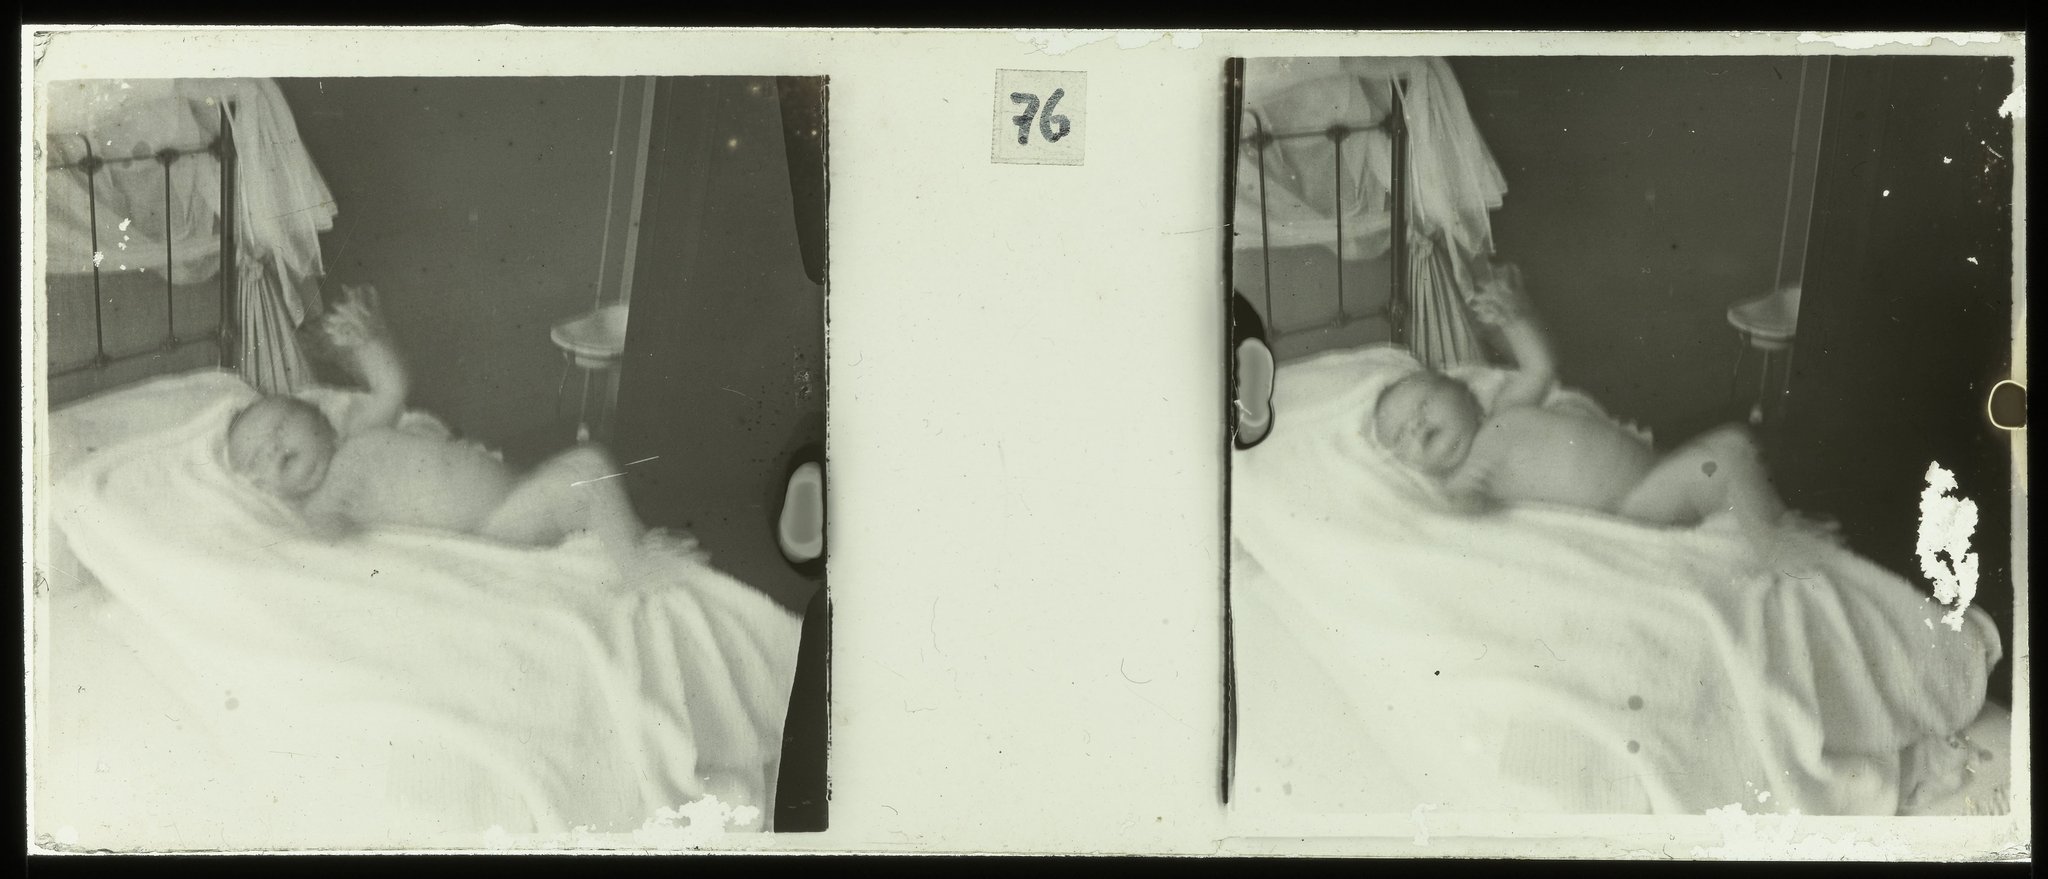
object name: stereograph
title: Gerard Brouwers, de pasgeboren zoon van planter Theodoor Brouwers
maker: theodoor brouwers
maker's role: amateurfotograaf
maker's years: 1874-1932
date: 1913-1930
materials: glass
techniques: photography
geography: suriname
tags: amsterdam, theodoor brouwers, suriname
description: In de periode 1911-1932 woonde op plantage Accaribo in Suriname de familie Brouwers van wie de foto's afkomstig zijn. Rond 1910 vond Theodoor Brouwers werk op plantage Accaribo. In 1929 werd hij eigenaar van de plantage. Op Accaribo werden in zijn tijd bananen geproduceerd en wat koffie.